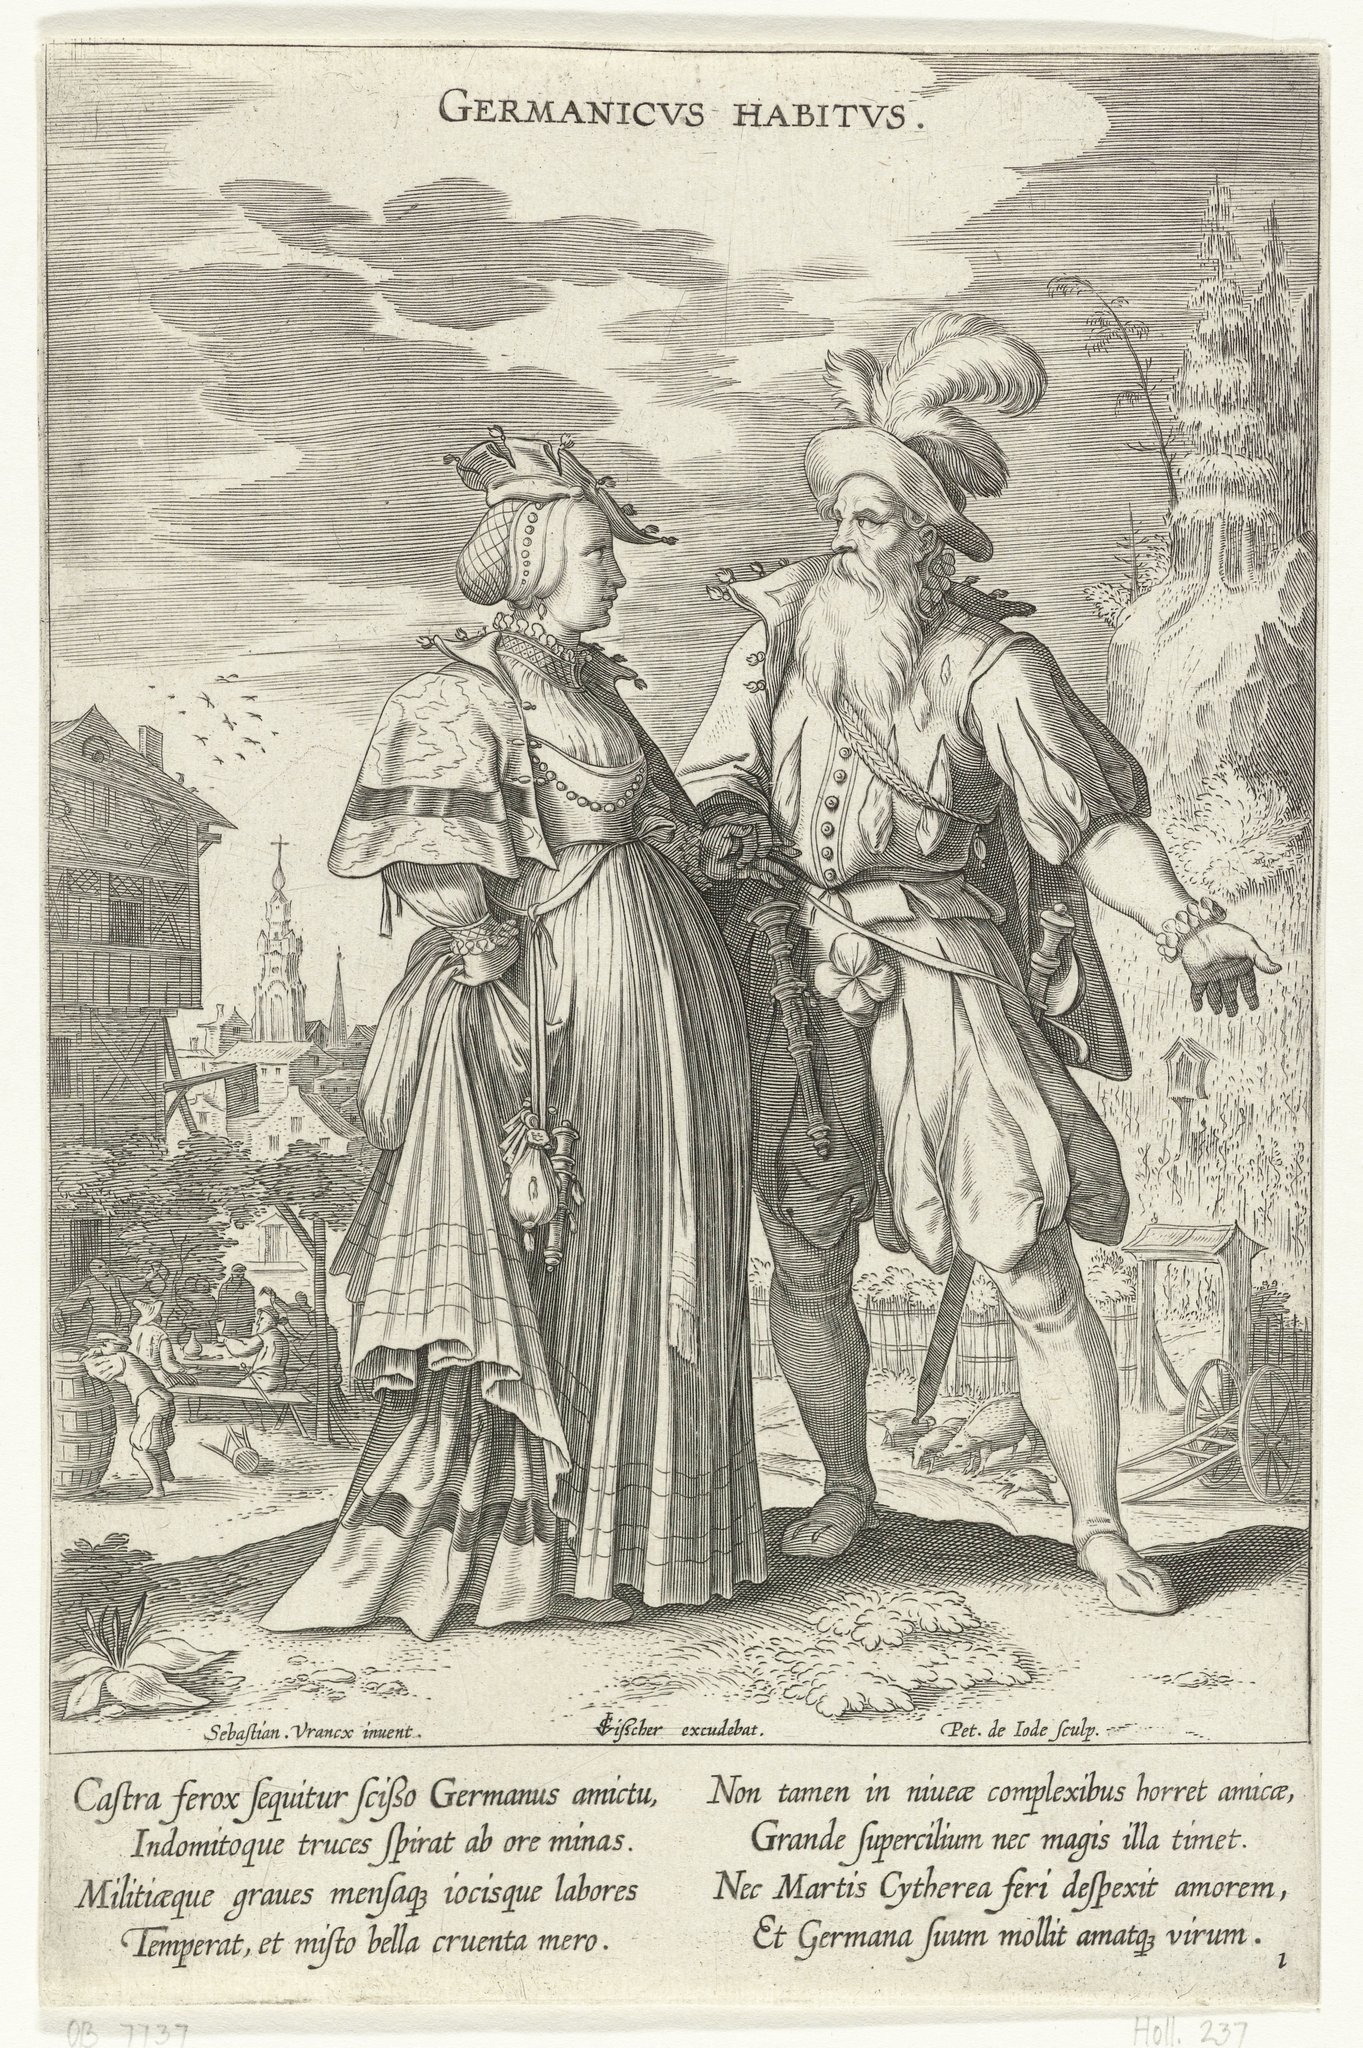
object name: costume print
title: Variarum Gentium Ornatus (Costumes of Different Nations)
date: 1605-1610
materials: paper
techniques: engraving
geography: amsterdam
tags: cape (+ women's clothes), other clothing accessories (scissors) (+ women's clothes), other clothing accessories (purse) (+ women's clothes), other clothing accessories (knife) (+ women's clothes), moustache, codpiece (cover for the genitals), head-gear: hat (+ men's clothes), styles of hairdress - aa - ~ women, head-gear: hat (+ women's clothes), piece of clothing covering the breast or décolleté, dress, gown (+ women's clothes), shoes, sandals (+ men's clothes), trousers, breeches, etc. (breeches) (+ men's clothes), whiskers, europeans: germans, belt, girdle, waistband (+ women's clothes), purse, money-bag (+ women's clothes), head-gear (with name) (+ women's clothes)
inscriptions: collector's mark: Lugt 240, title: ‘Germanicvs habitvs’, caption: ‘Castra ferox sequitur scisso Germanus amictu, Indomitoque truces spirat ab ore minas. Militiaeque graues mensaque iocisque labores Temperat, et misto bella cruenta mero. Non tamen in niueae complexibus horret amicae, Grande supercilium nec magis illa timet. Nec Martis Cytherea feri despexit amorem, Et Germana suum mollit amatque virum. ’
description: This series illustrates both the local scenery and the aristocratic fashions of Germany 1, France 2, Rome 3, Milan 4, the Netherlands 5 and Spain 6. Sometimes it is possible to spot famous monuments in the distance, such as Trajan’s Column in Rome. The inscriptions rarely refer to clothing, but plate 2 notes that the French constantly update their outfits – an oft-repeated stereotype of the period.